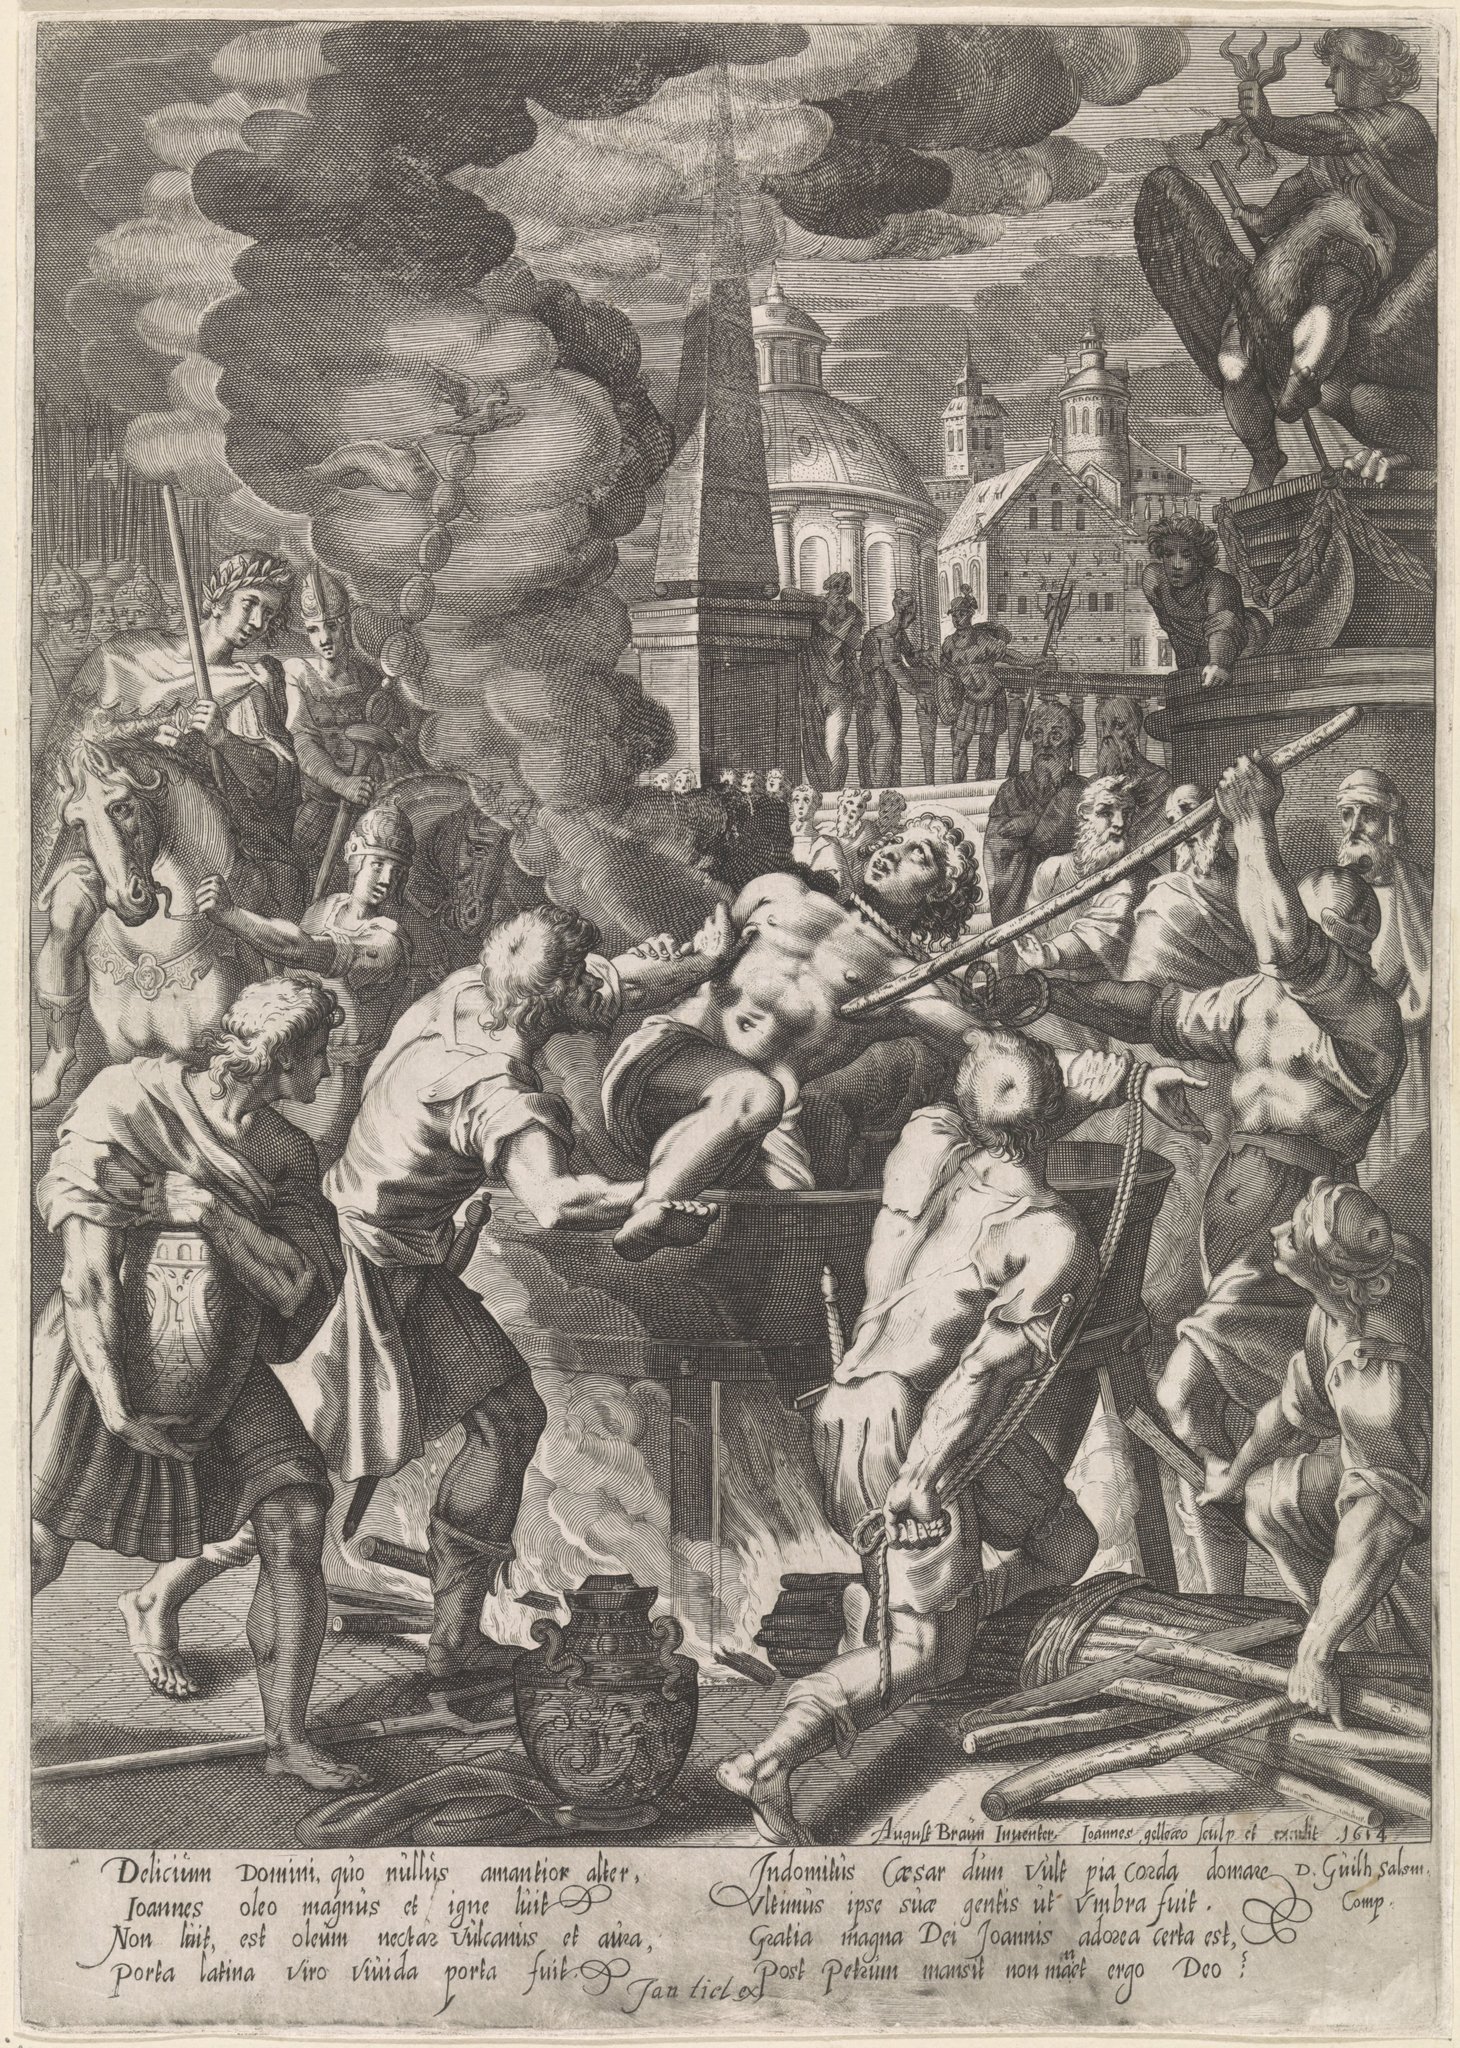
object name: print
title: Martelaarschap van Johannes de evangelist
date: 1614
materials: paper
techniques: engraving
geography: antwerp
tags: the apostle john the evangelist; possible attributes: book, cauldron, chalice with snake, eagle, palm, scroll - martyrdom, suffering, misfortune, death of male saint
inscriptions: collector's mark: Lugt 240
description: Johannes de evangelist wordt door Romeinse soldaten ondergedompeld in een vat met kokende olie, onder het goedkeurend oog van keizer Domitianus. Johannes sterft echter niet, maar komt verjongd tevoorschijn. De prent heeft een Latijns onderschrift.